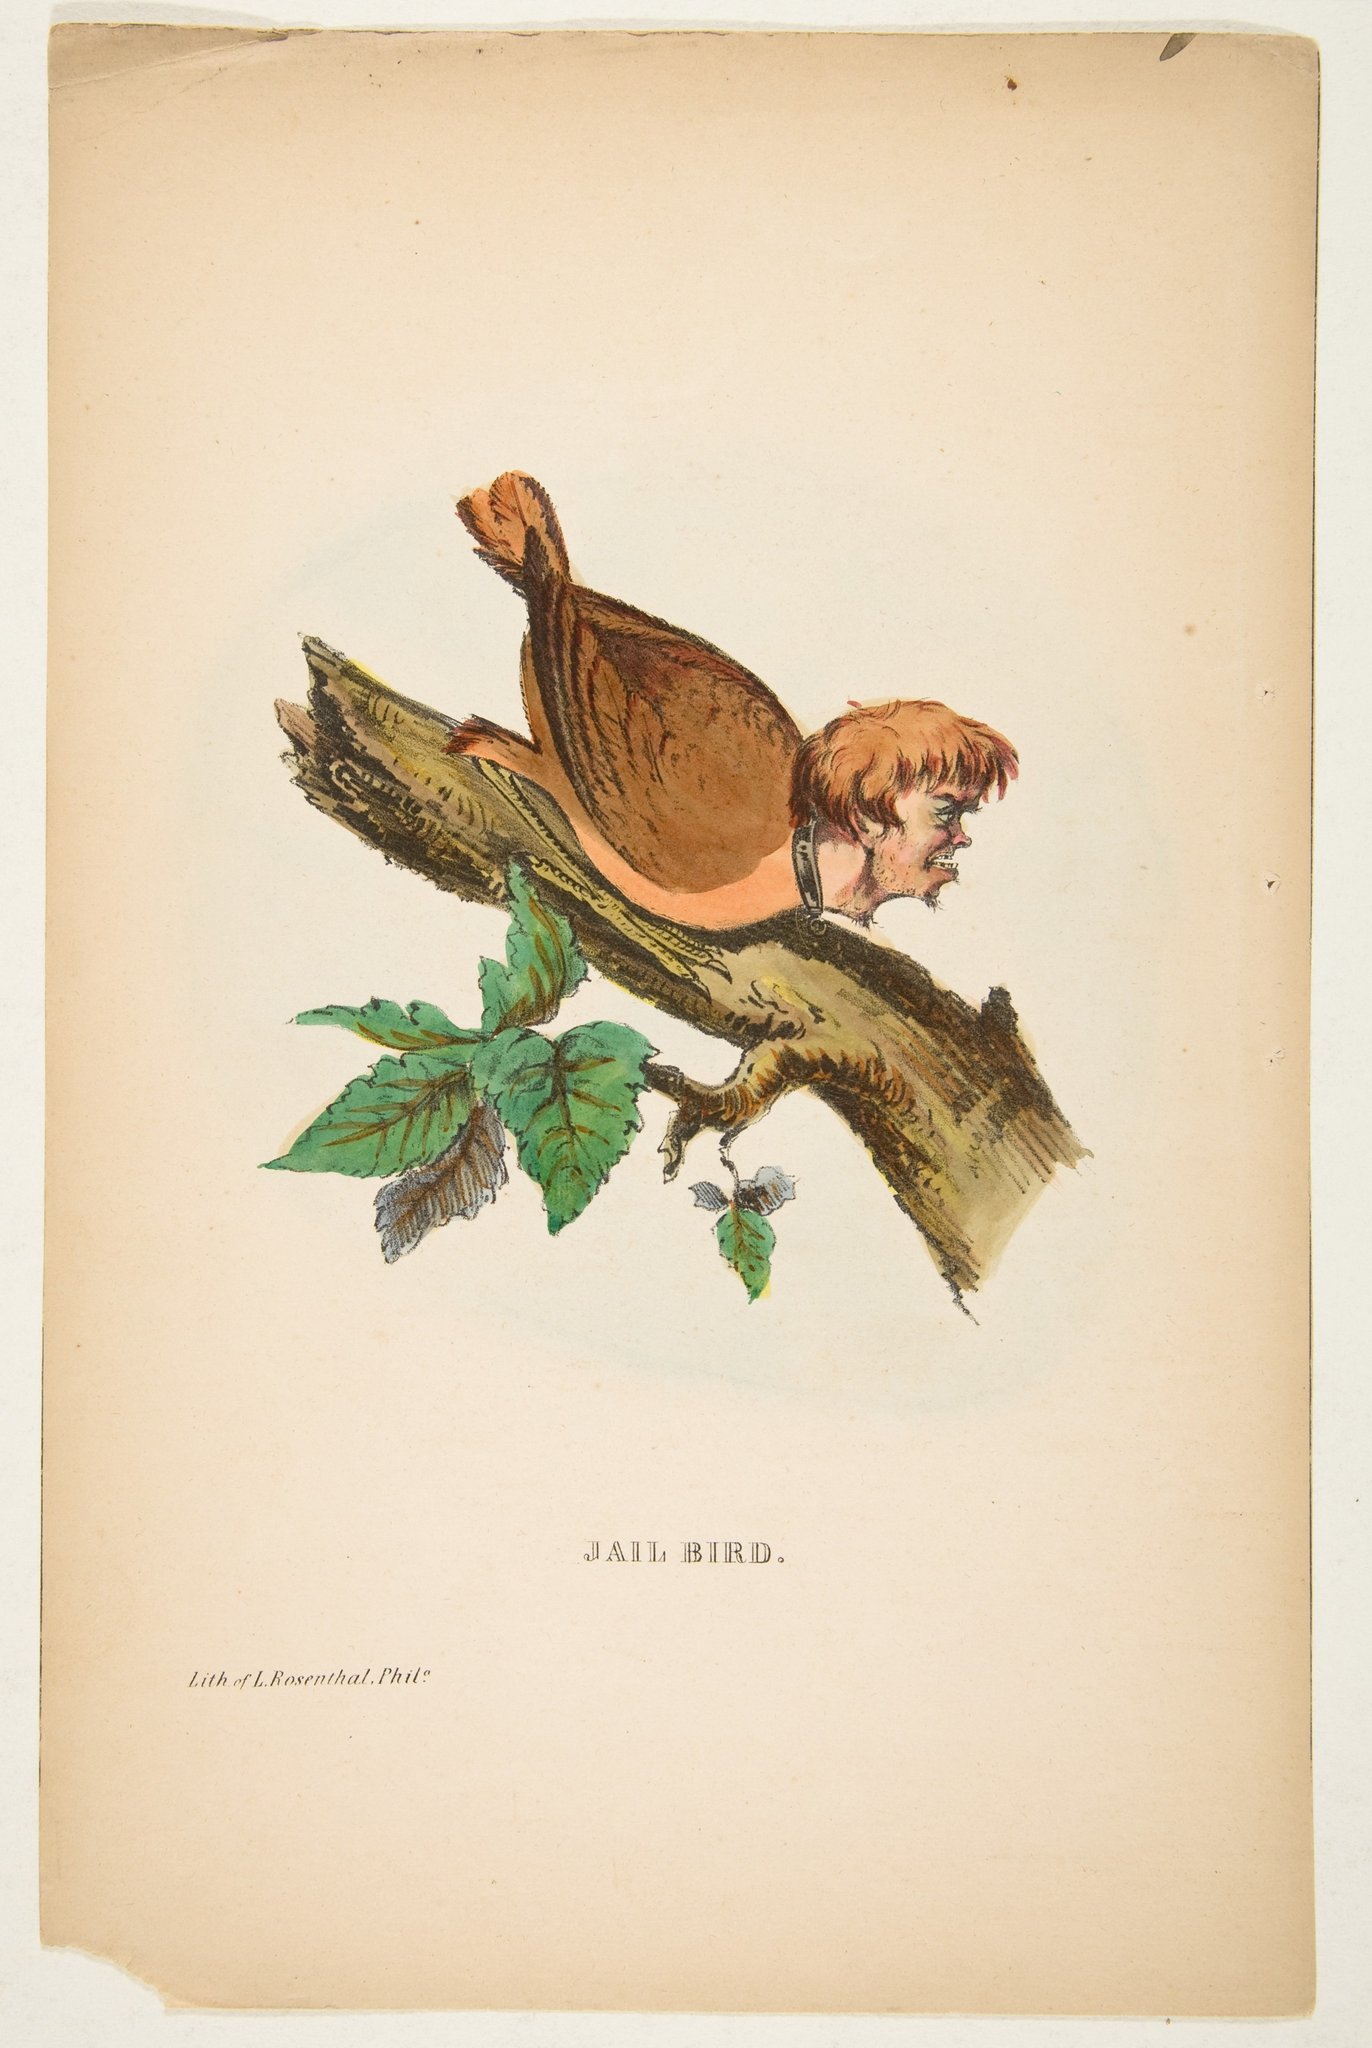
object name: print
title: Jail Bird, from "The Comic Natural History of the Human Race"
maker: henry louis stephens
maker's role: artist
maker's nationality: american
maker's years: 1824-1882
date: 1851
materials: watercolor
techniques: lithograph